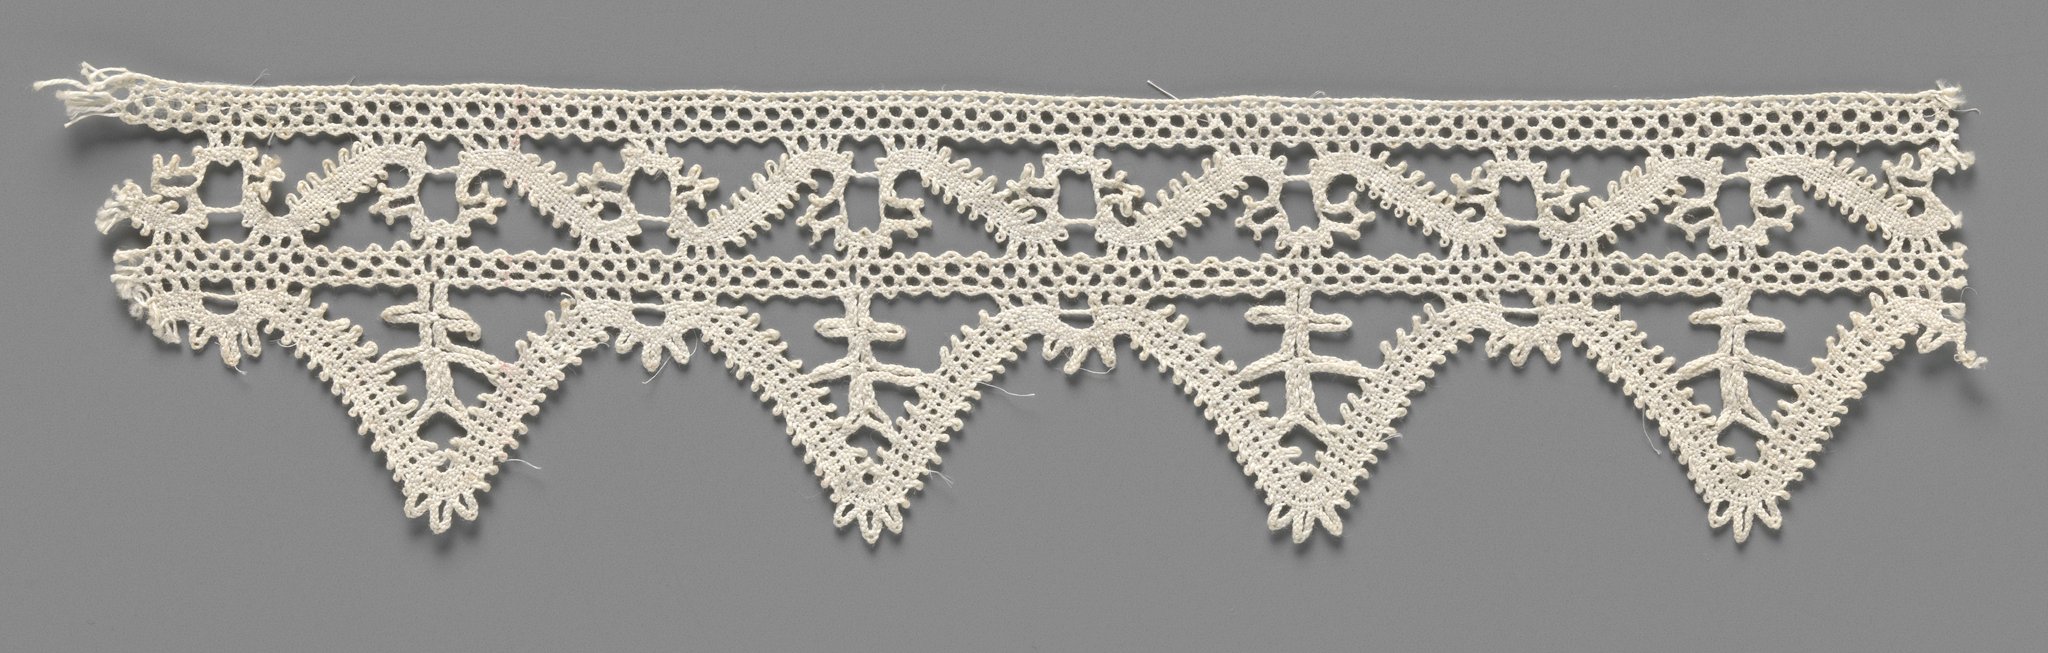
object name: strip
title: Strook kloskant met driehoekige schulpen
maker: Anonymous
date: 1925-1936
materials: cotton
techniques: lace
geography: pescocostanzo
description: Strook naturelkleurige kloskant. Het zich herhalende en symmetrische patroon bestaat uit een opengewerkte band met een hoefijzervormig motiefje tussen twee schuingeplaatste lijnen. Onder de band hangen opengewerkte driehoekige schulpen, steeds één schulp onder één hoefijzer met schuine lijnen. Het betreft 20e-eeuws kant gemaakt naar een 16e-eeuws patroon.